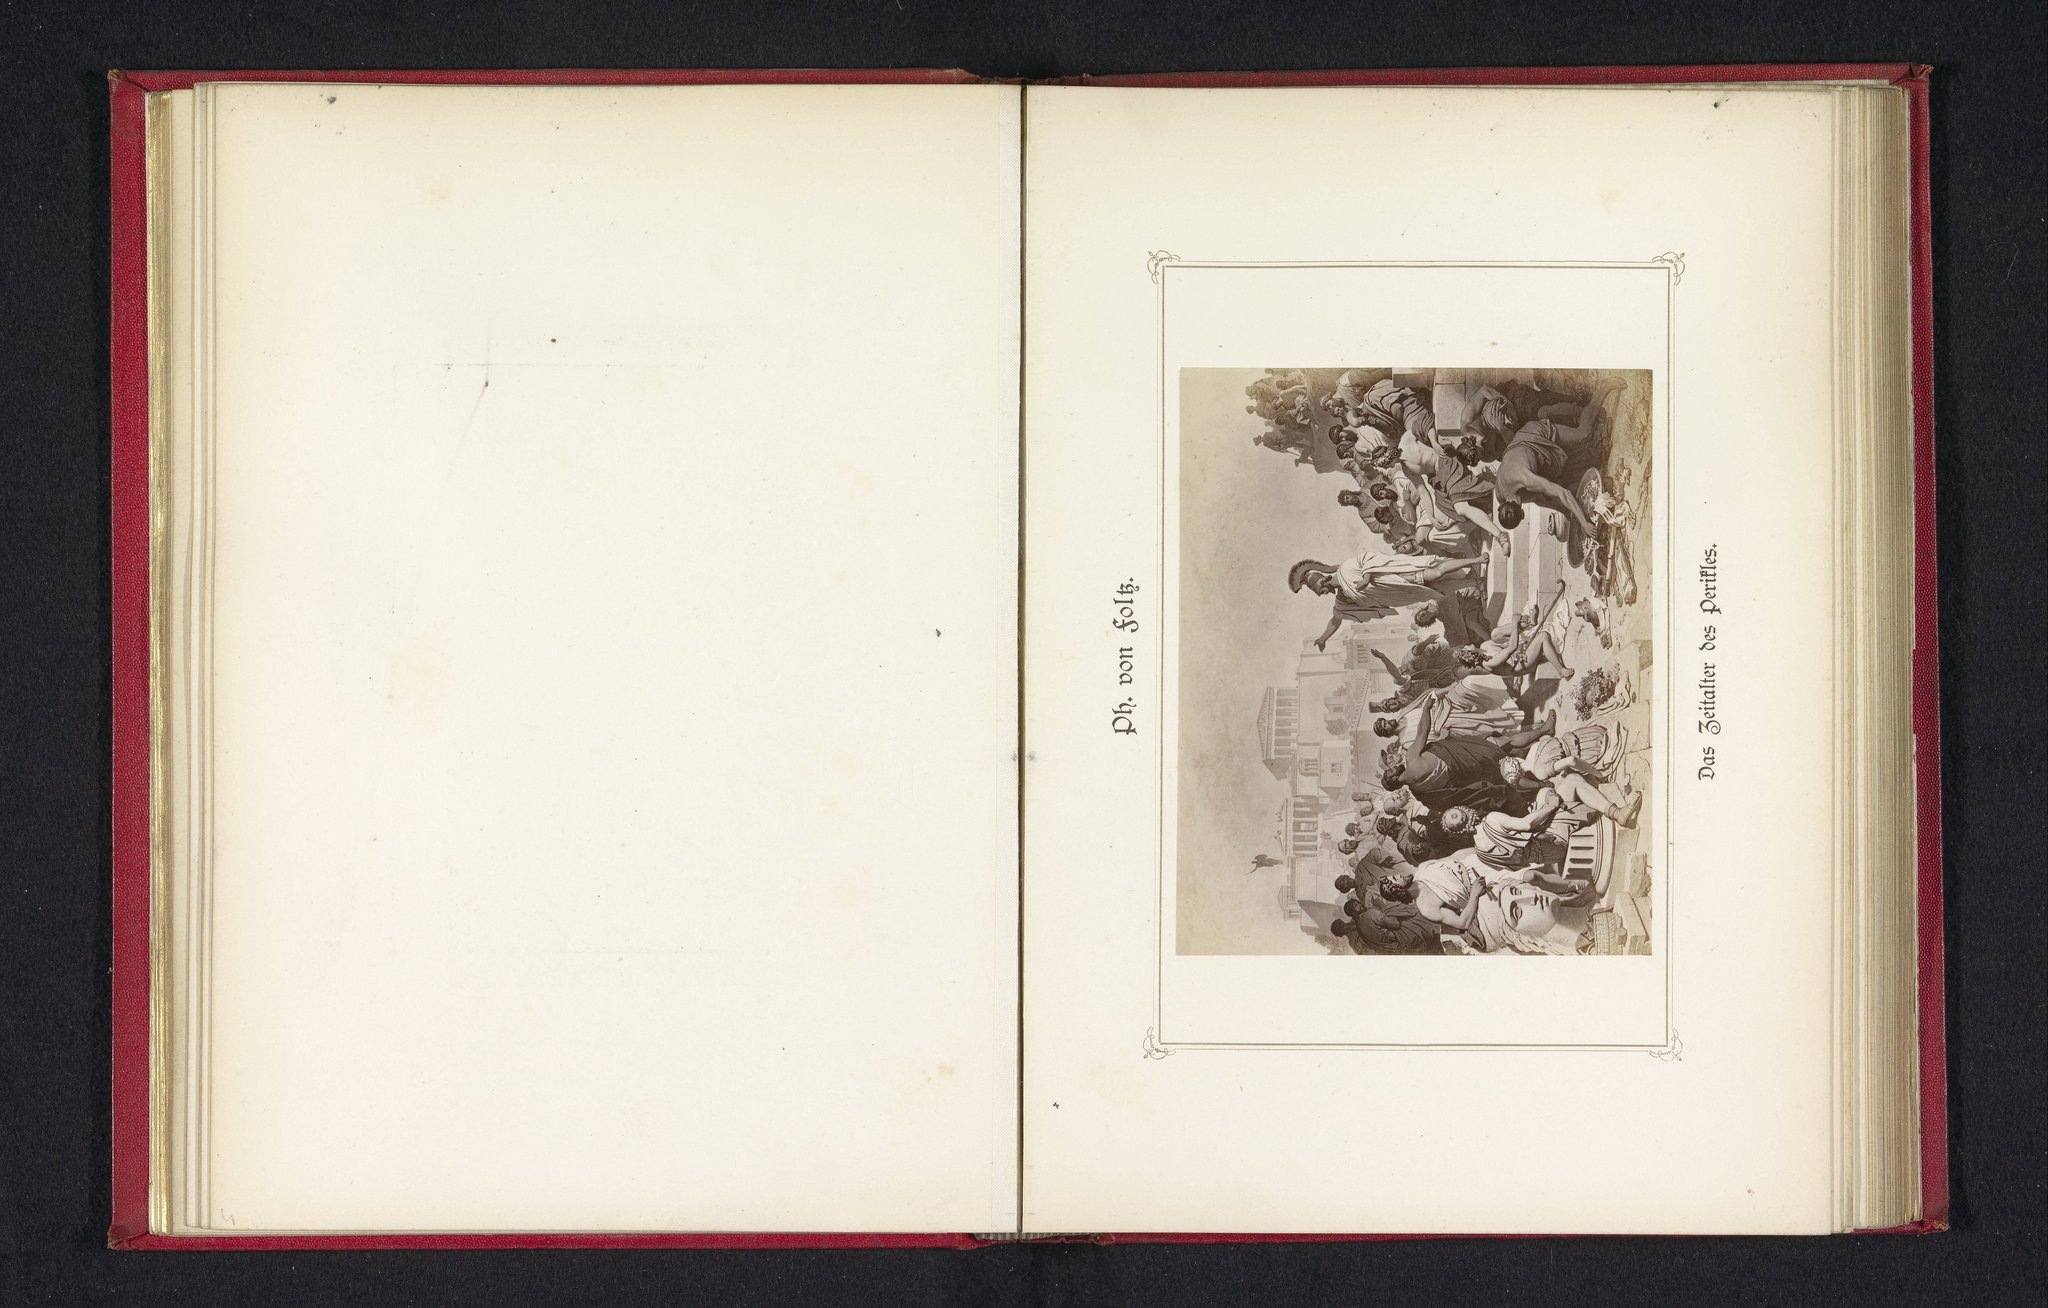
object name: photograph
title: Das Zeitalter des Pericles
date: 1875-1880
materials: photographic support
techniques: albumen print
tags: (story of) pericles